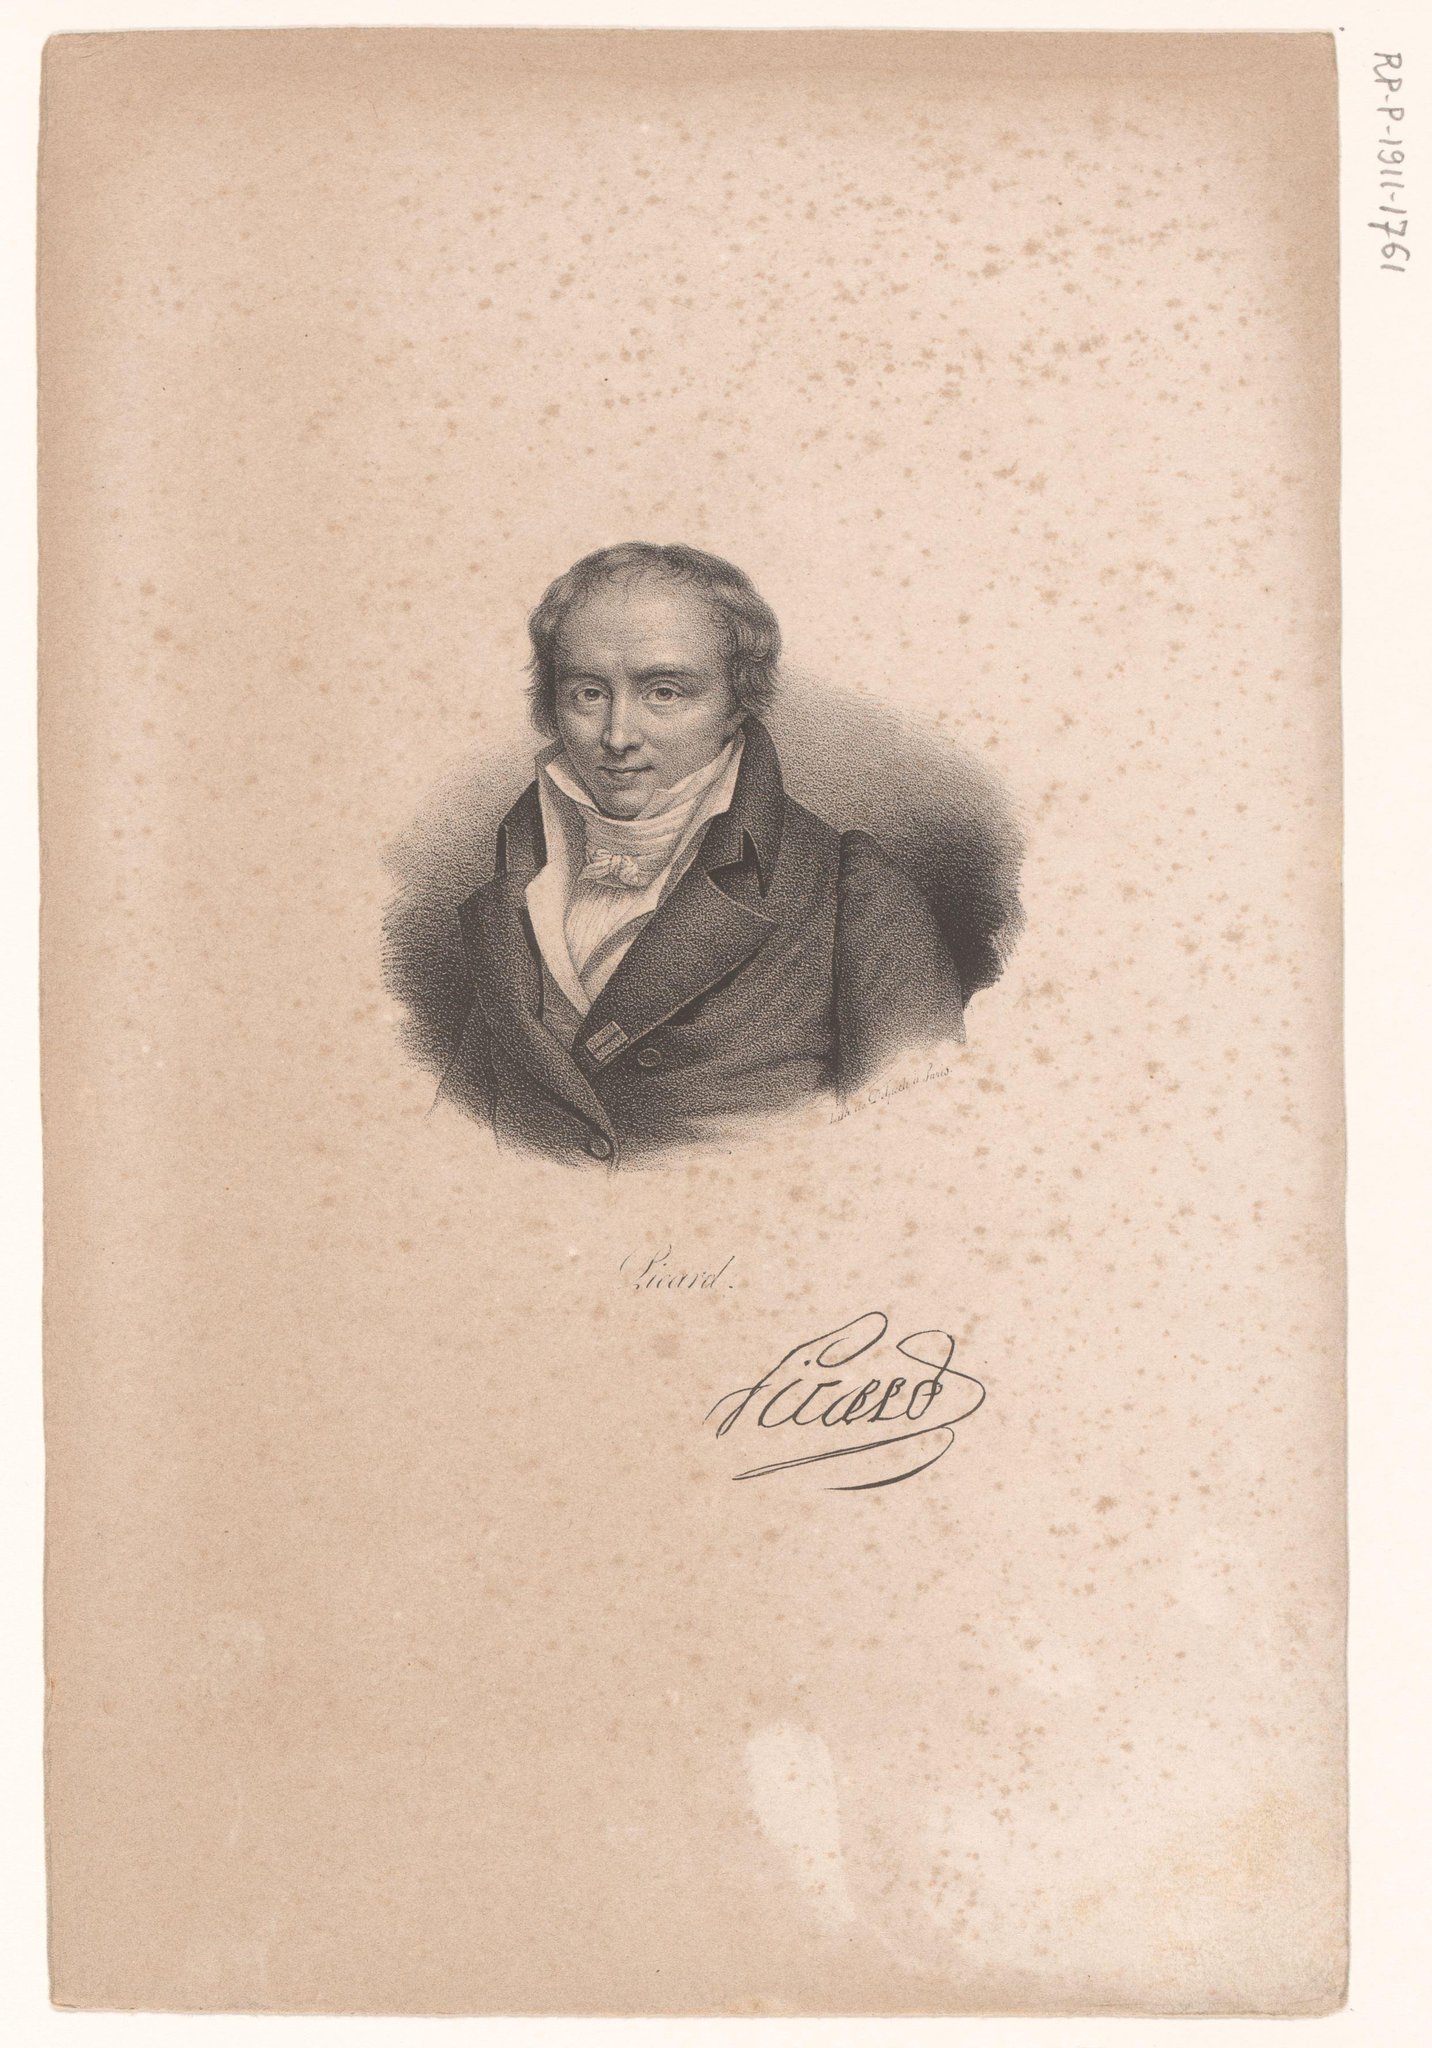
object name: print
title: Portret van Louis-Benoît Picard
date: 1818-1842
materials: paper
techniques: lithograph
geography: paris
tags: paris, historical persons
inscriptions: collector's mark: Lugt 2228a